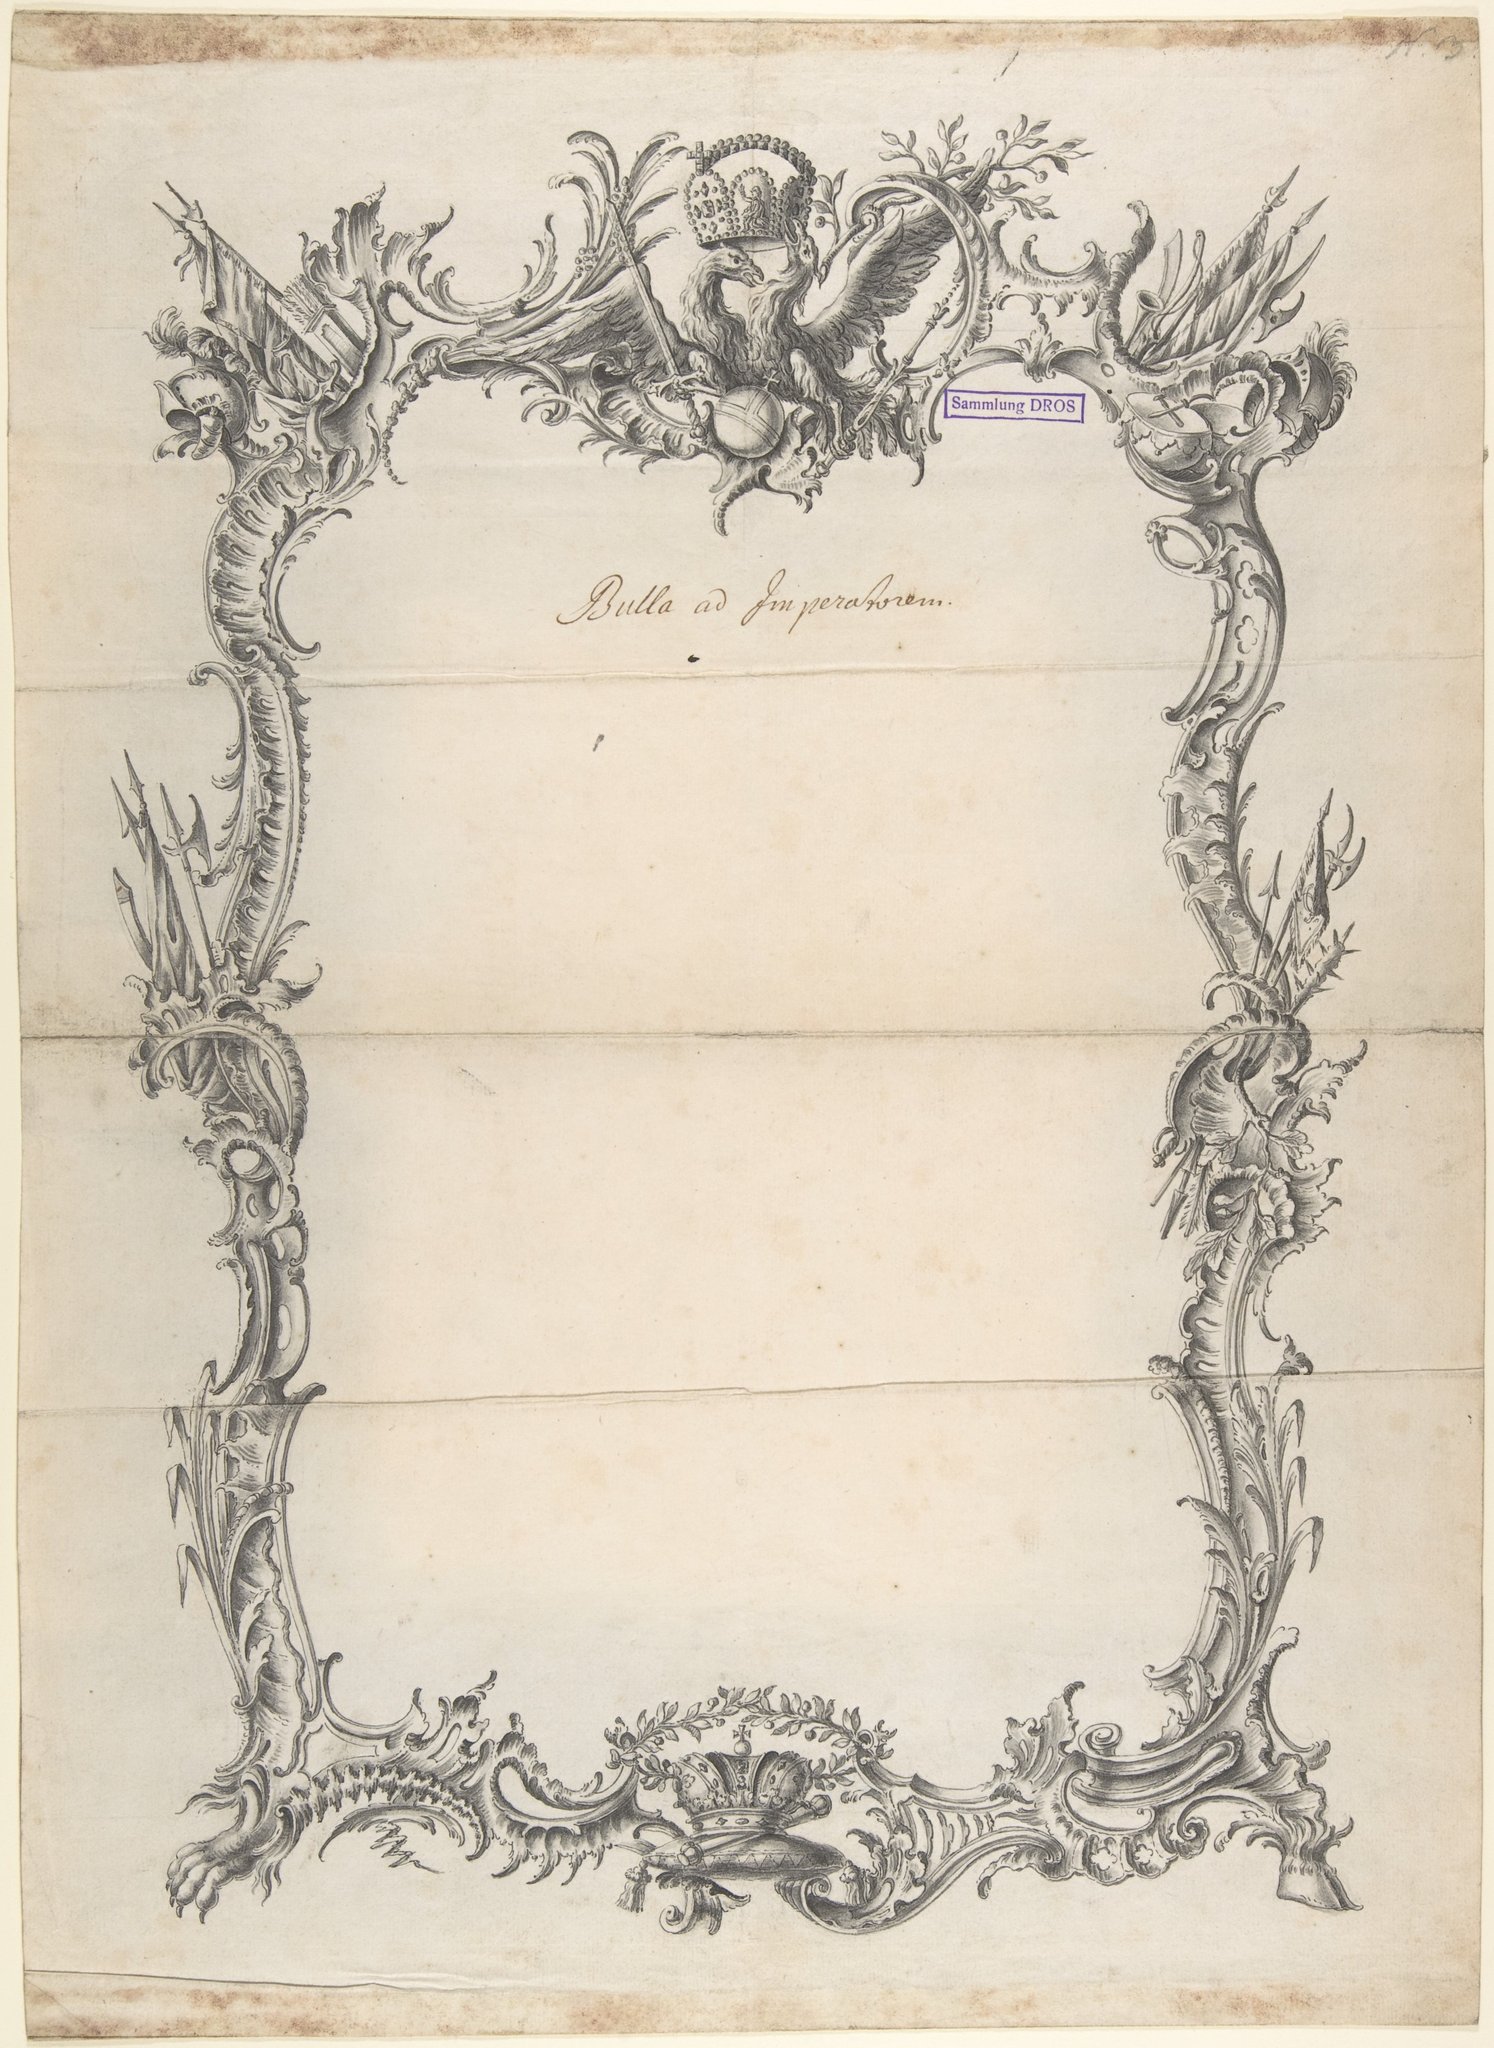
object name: drawing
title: Design for a frame with Eagles and Trophies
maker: johann oktavian salver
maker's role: artist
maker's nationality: german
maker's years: 1732-1788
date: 1750-1788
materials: chalk, ink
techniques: brush, incising, transfer, wash